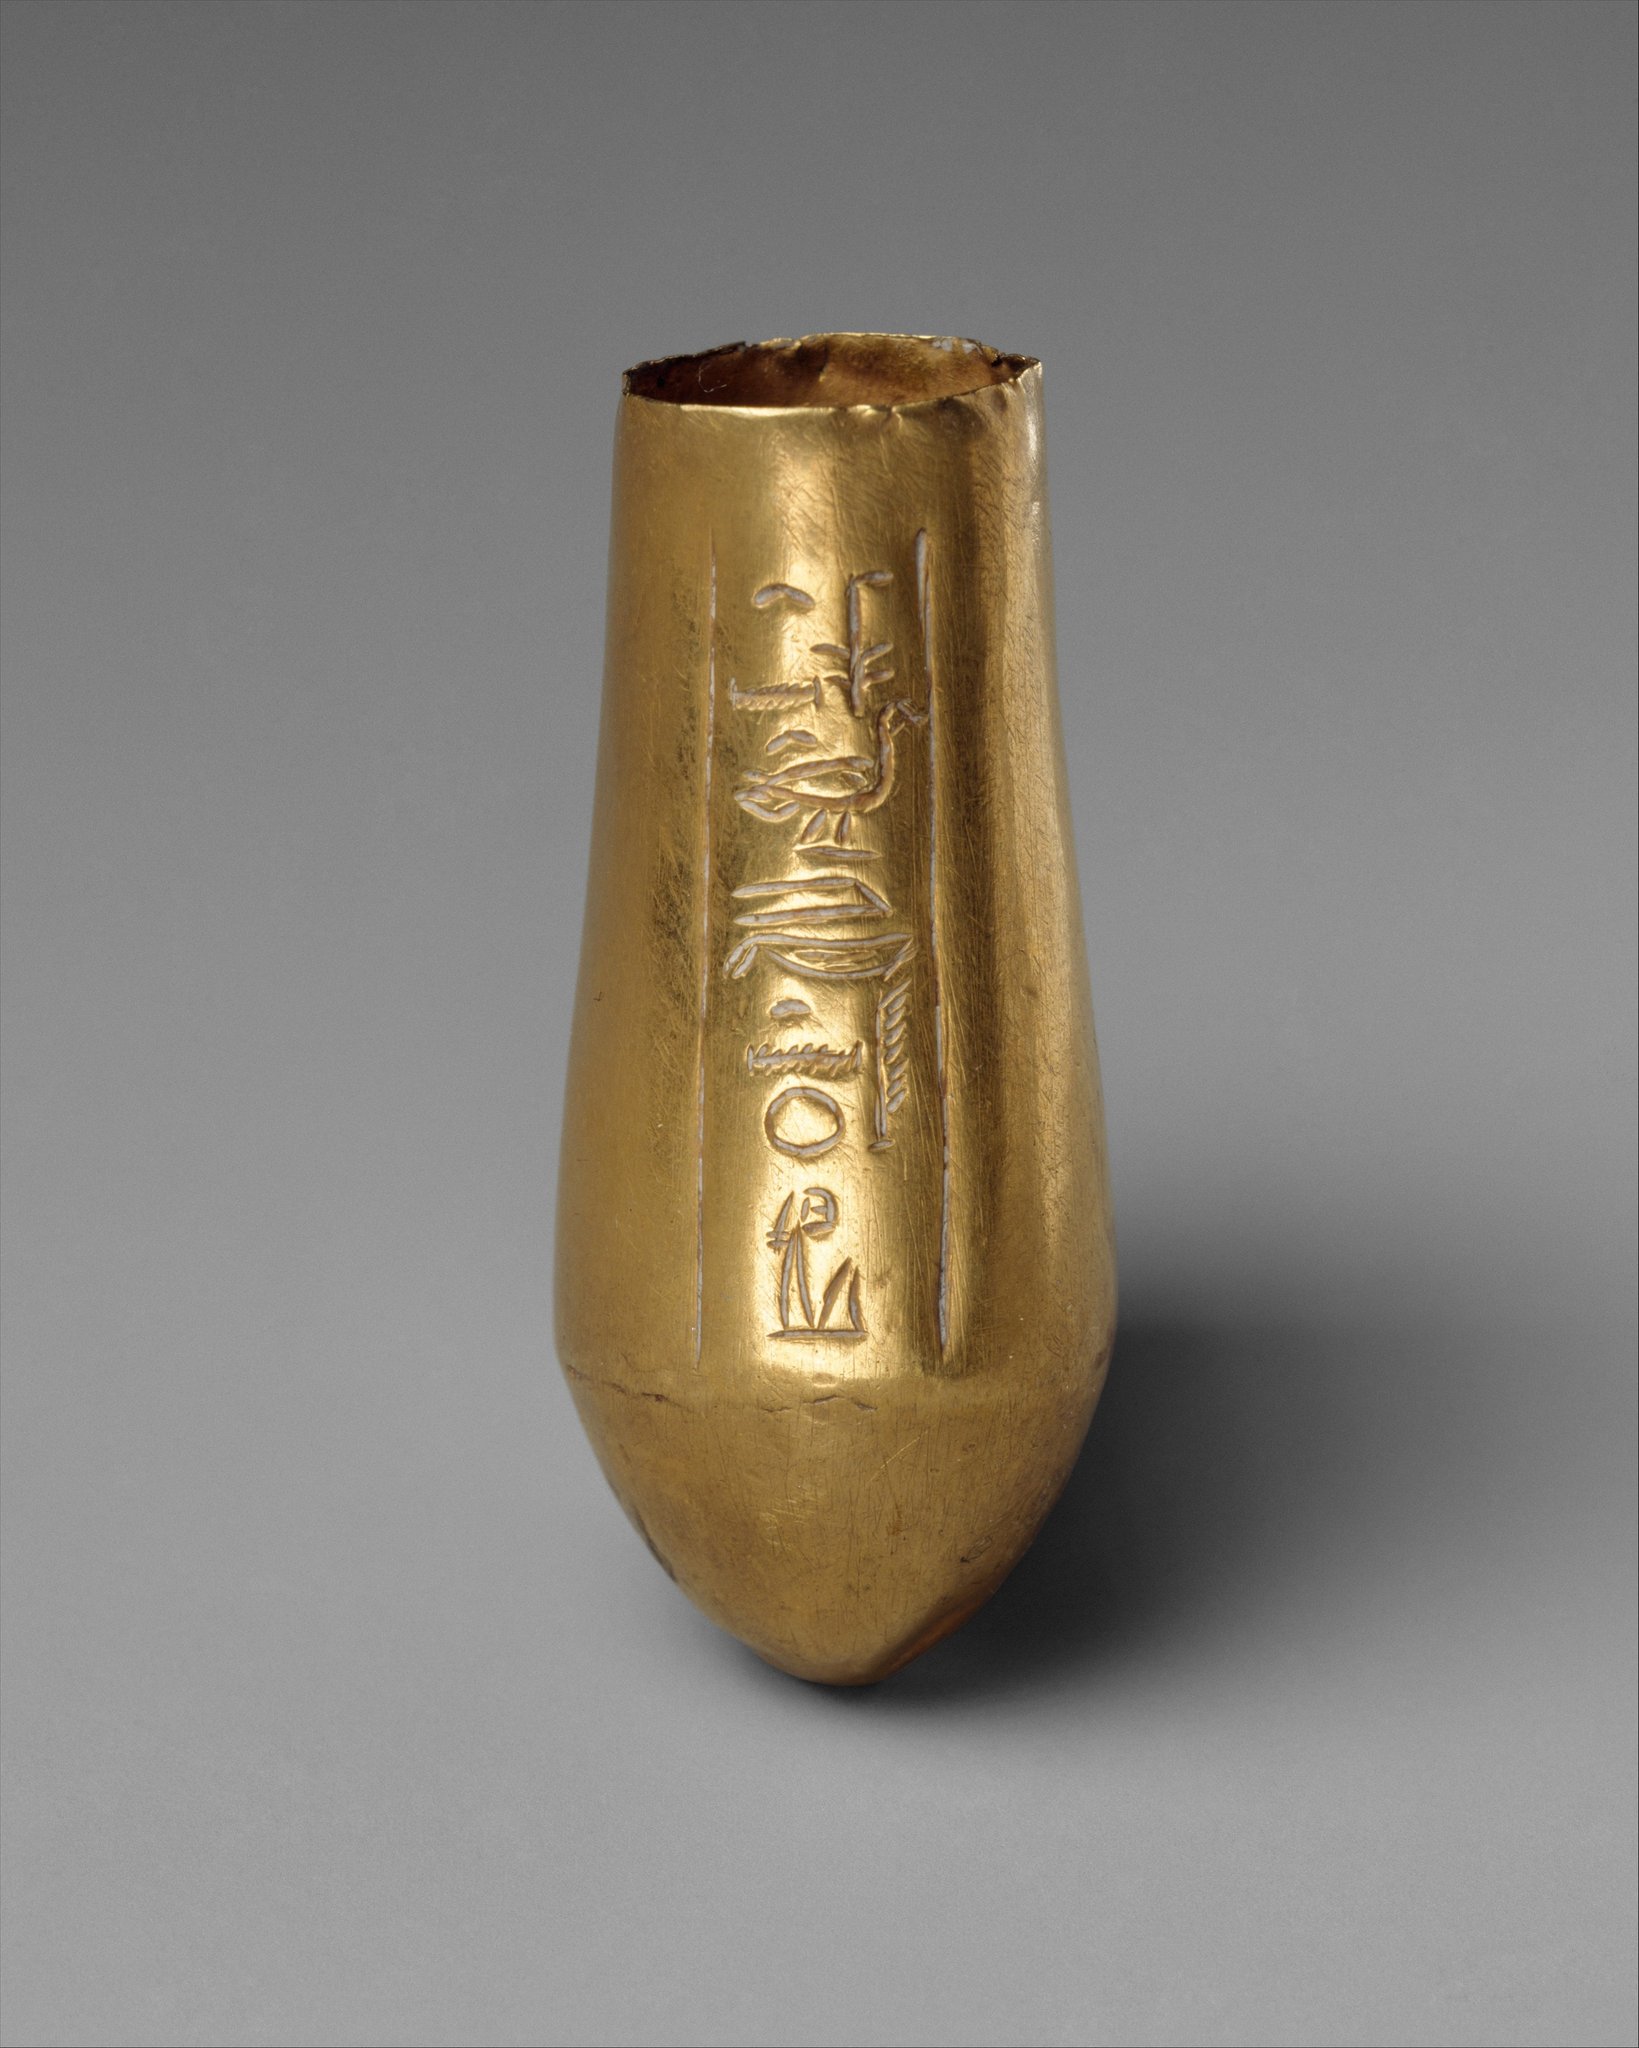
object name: scepter, terminal, meketaten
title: Terminal, possibly for a scepter, with the name of Meketaten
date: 1353-1336 BCE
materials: gold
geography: middle egypt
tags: hieroglyphs